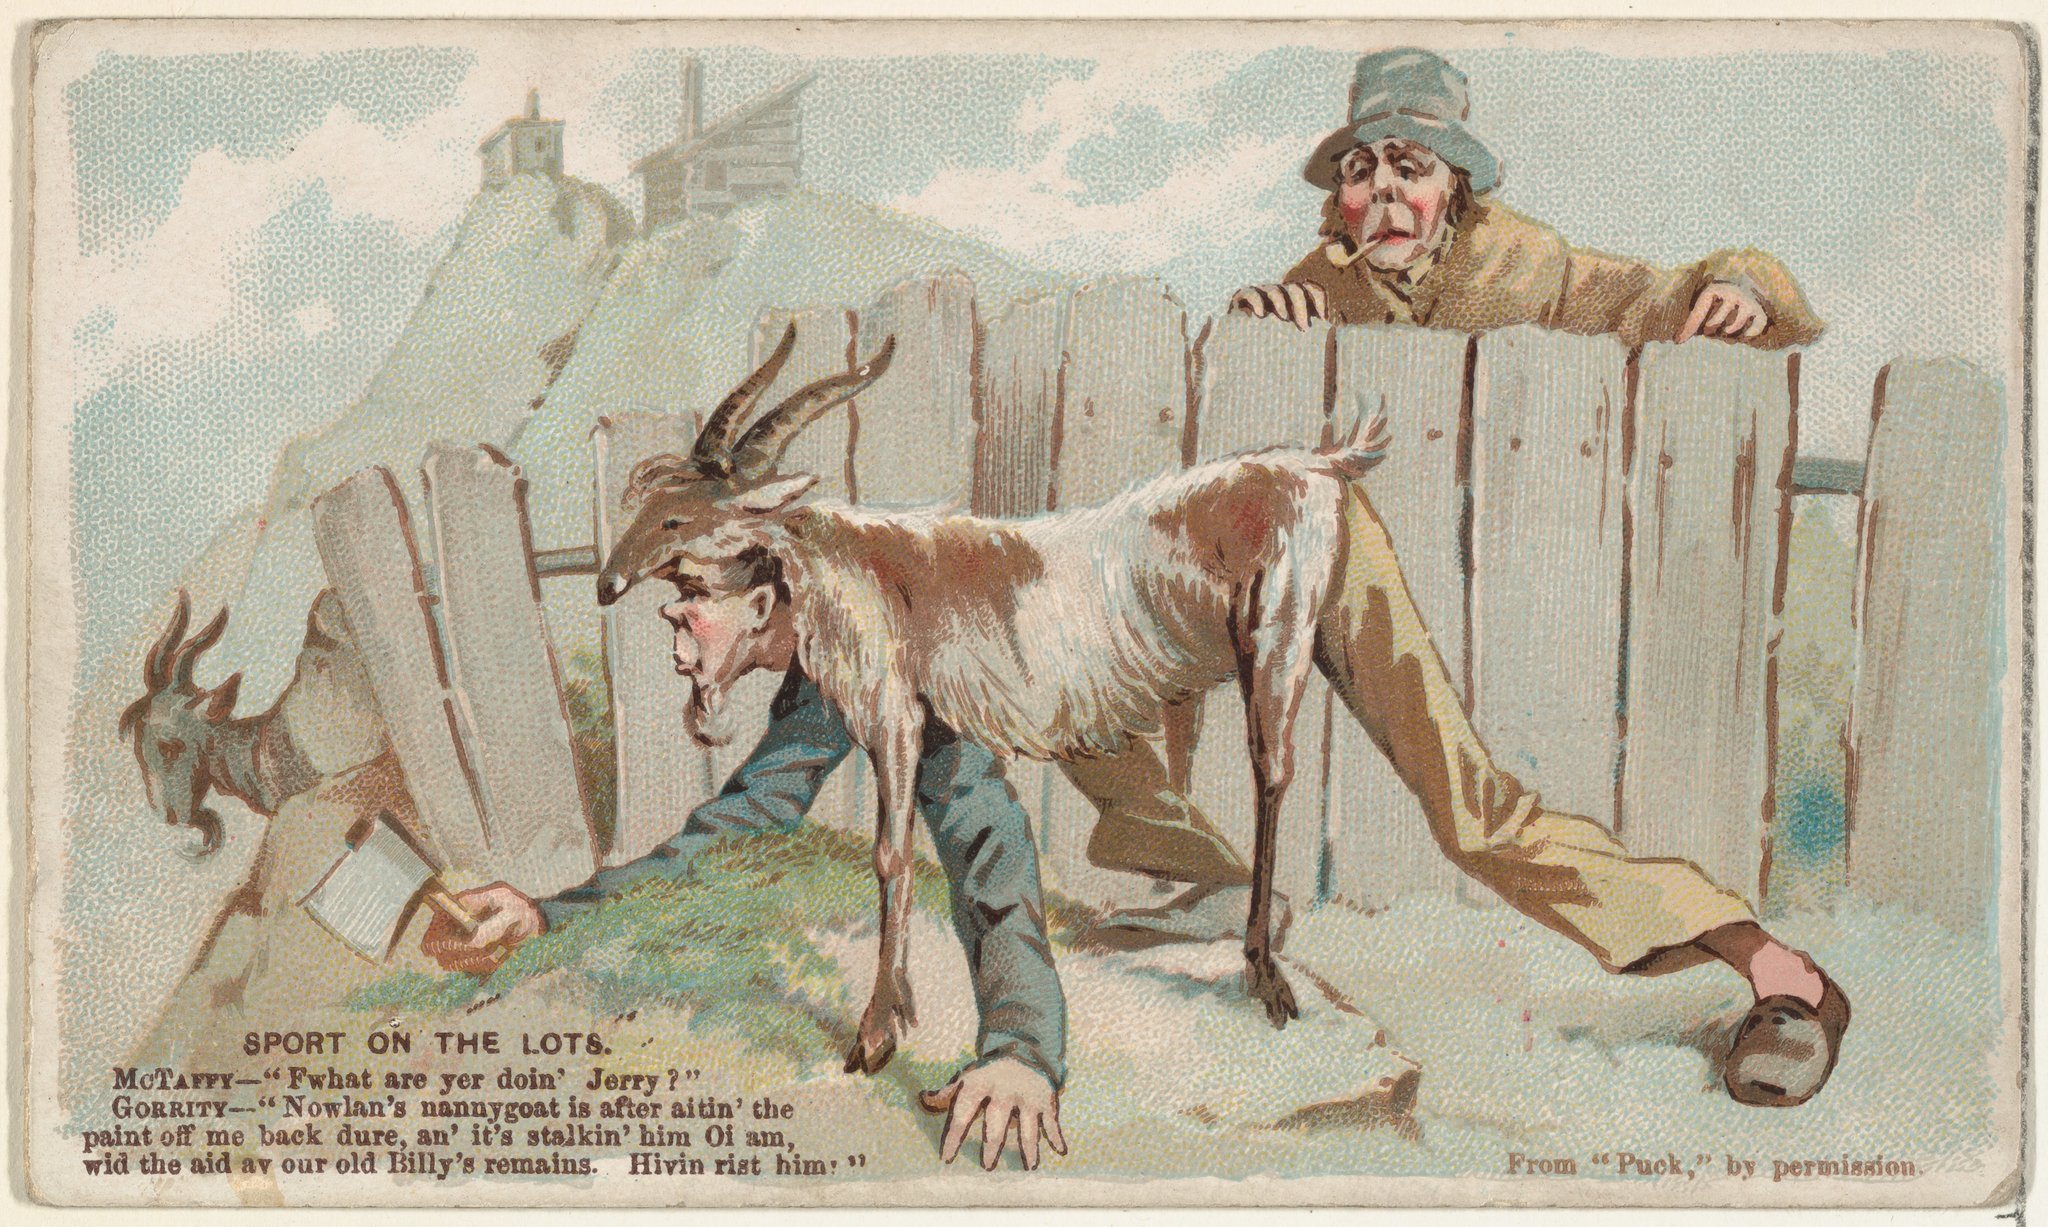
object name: print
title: Sport on the Lots, from the Snapshots from "Puck" series (N128) issued by Duke Sons & Co. to promote Honest Long Cut Tobacco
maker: w. duke, sons & co.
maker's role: publisher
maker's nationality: american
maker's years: 1870-1920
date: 1888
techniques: color lithograph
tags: men,goats